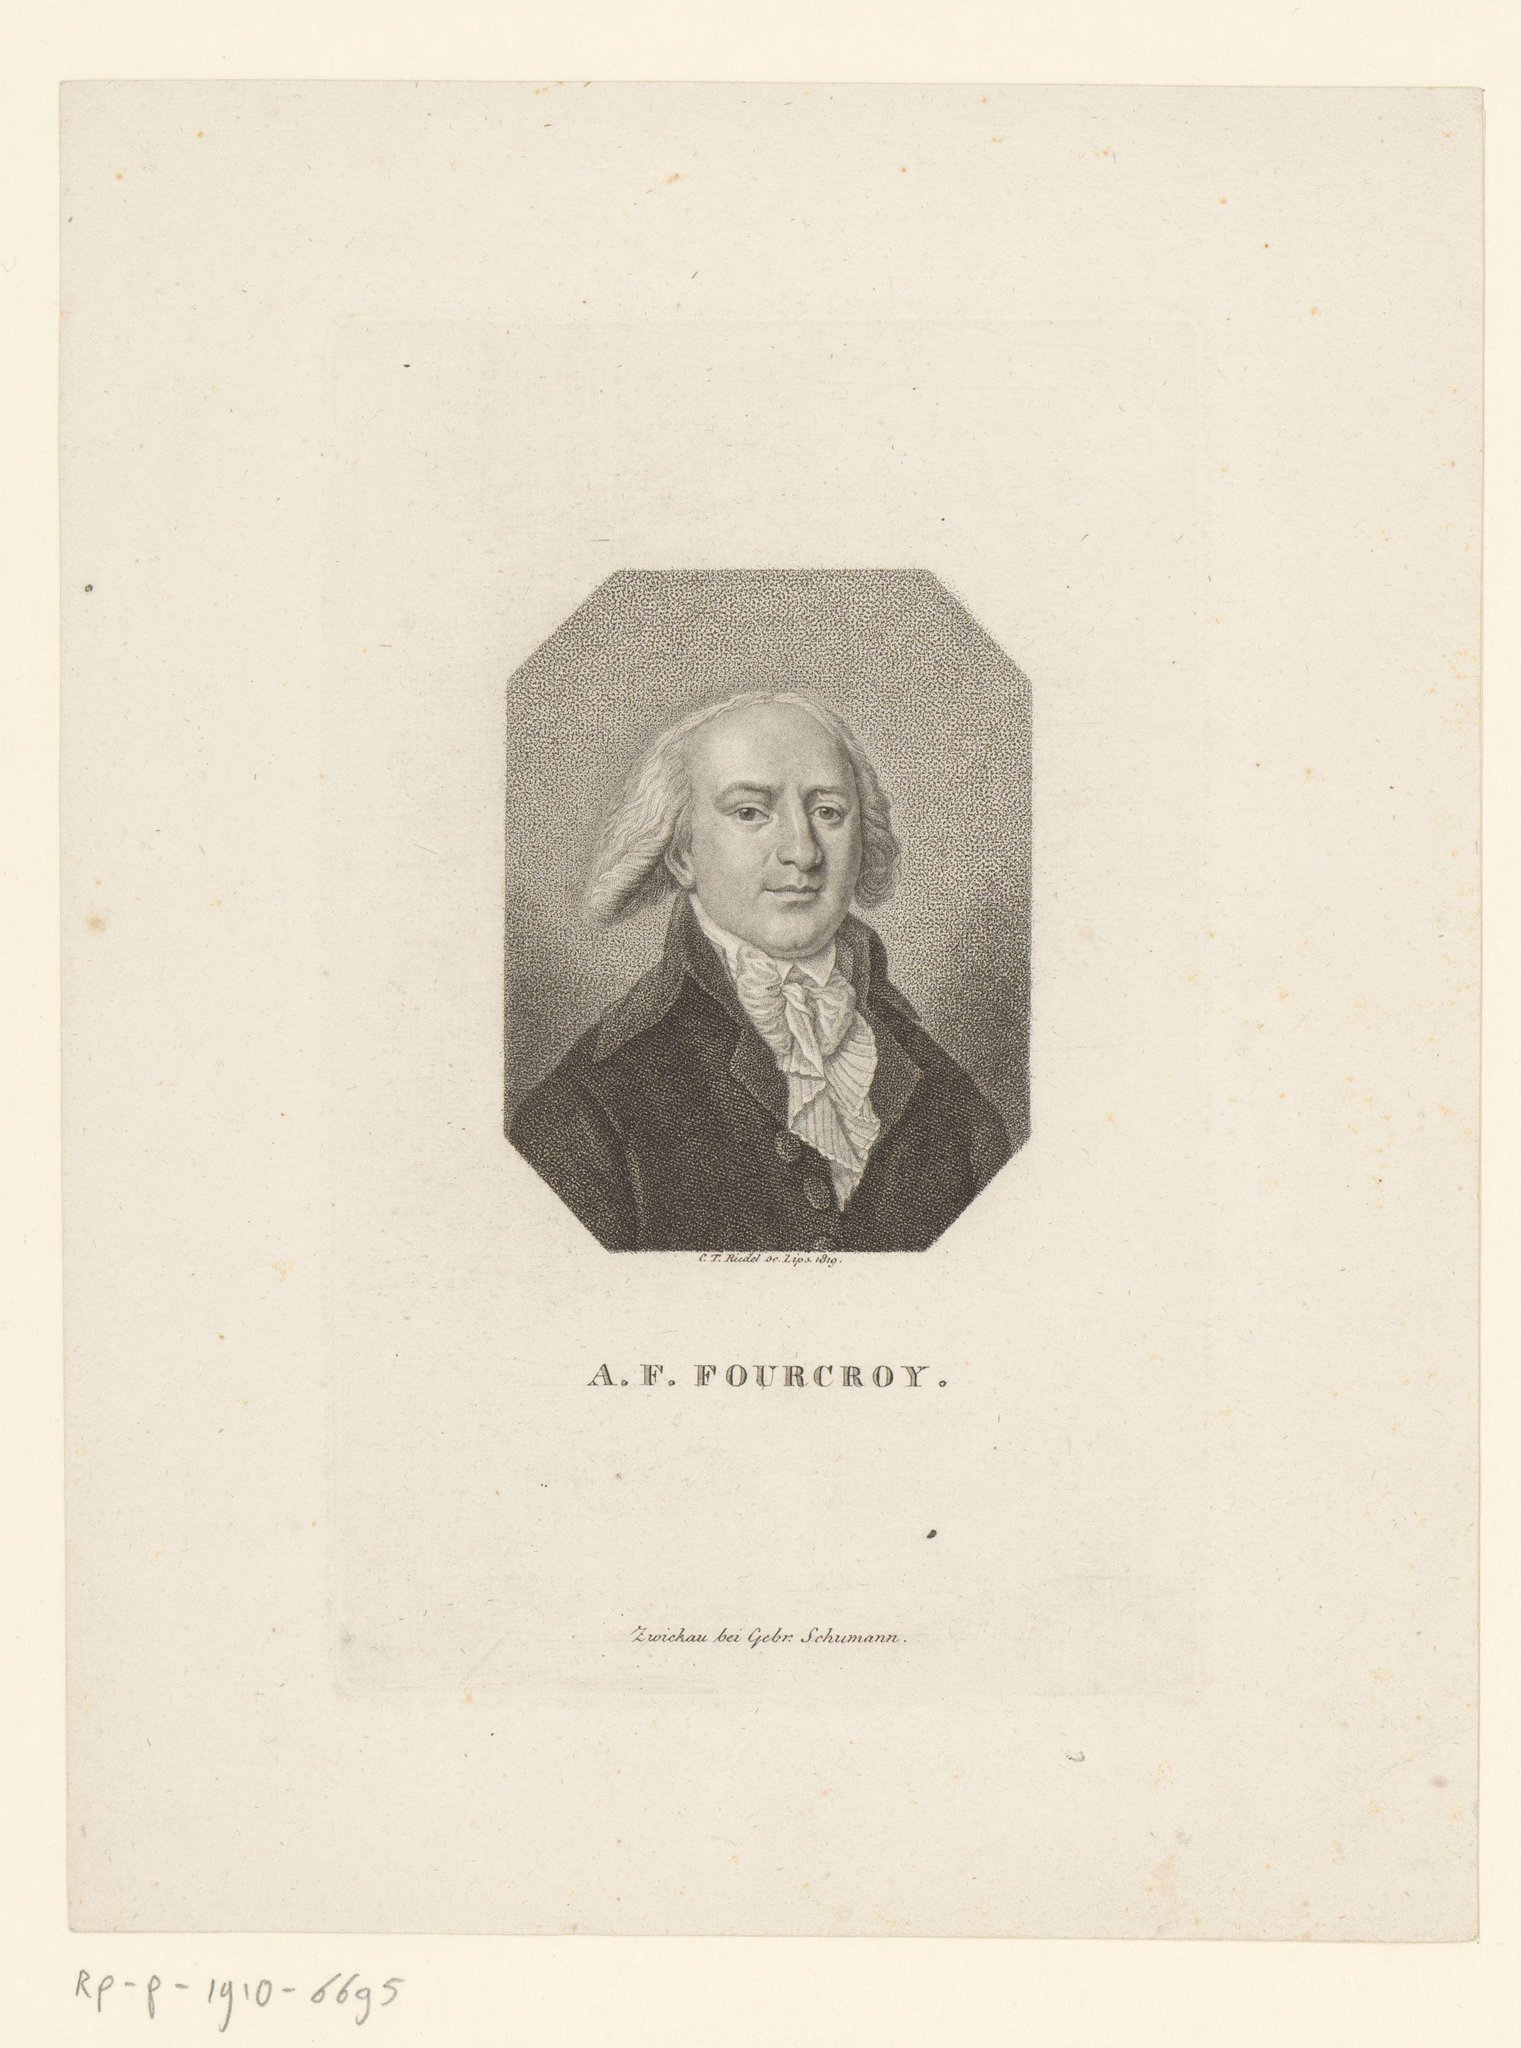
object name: print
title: Portret van Antoine François de Fourcroy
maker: karl traugott riedel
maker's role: print maker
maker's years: 1769-1832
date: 1819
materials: paper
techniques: engraving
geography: leipzig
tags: paris, politician, historical persons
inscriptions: collector's mark: Lugt 2228